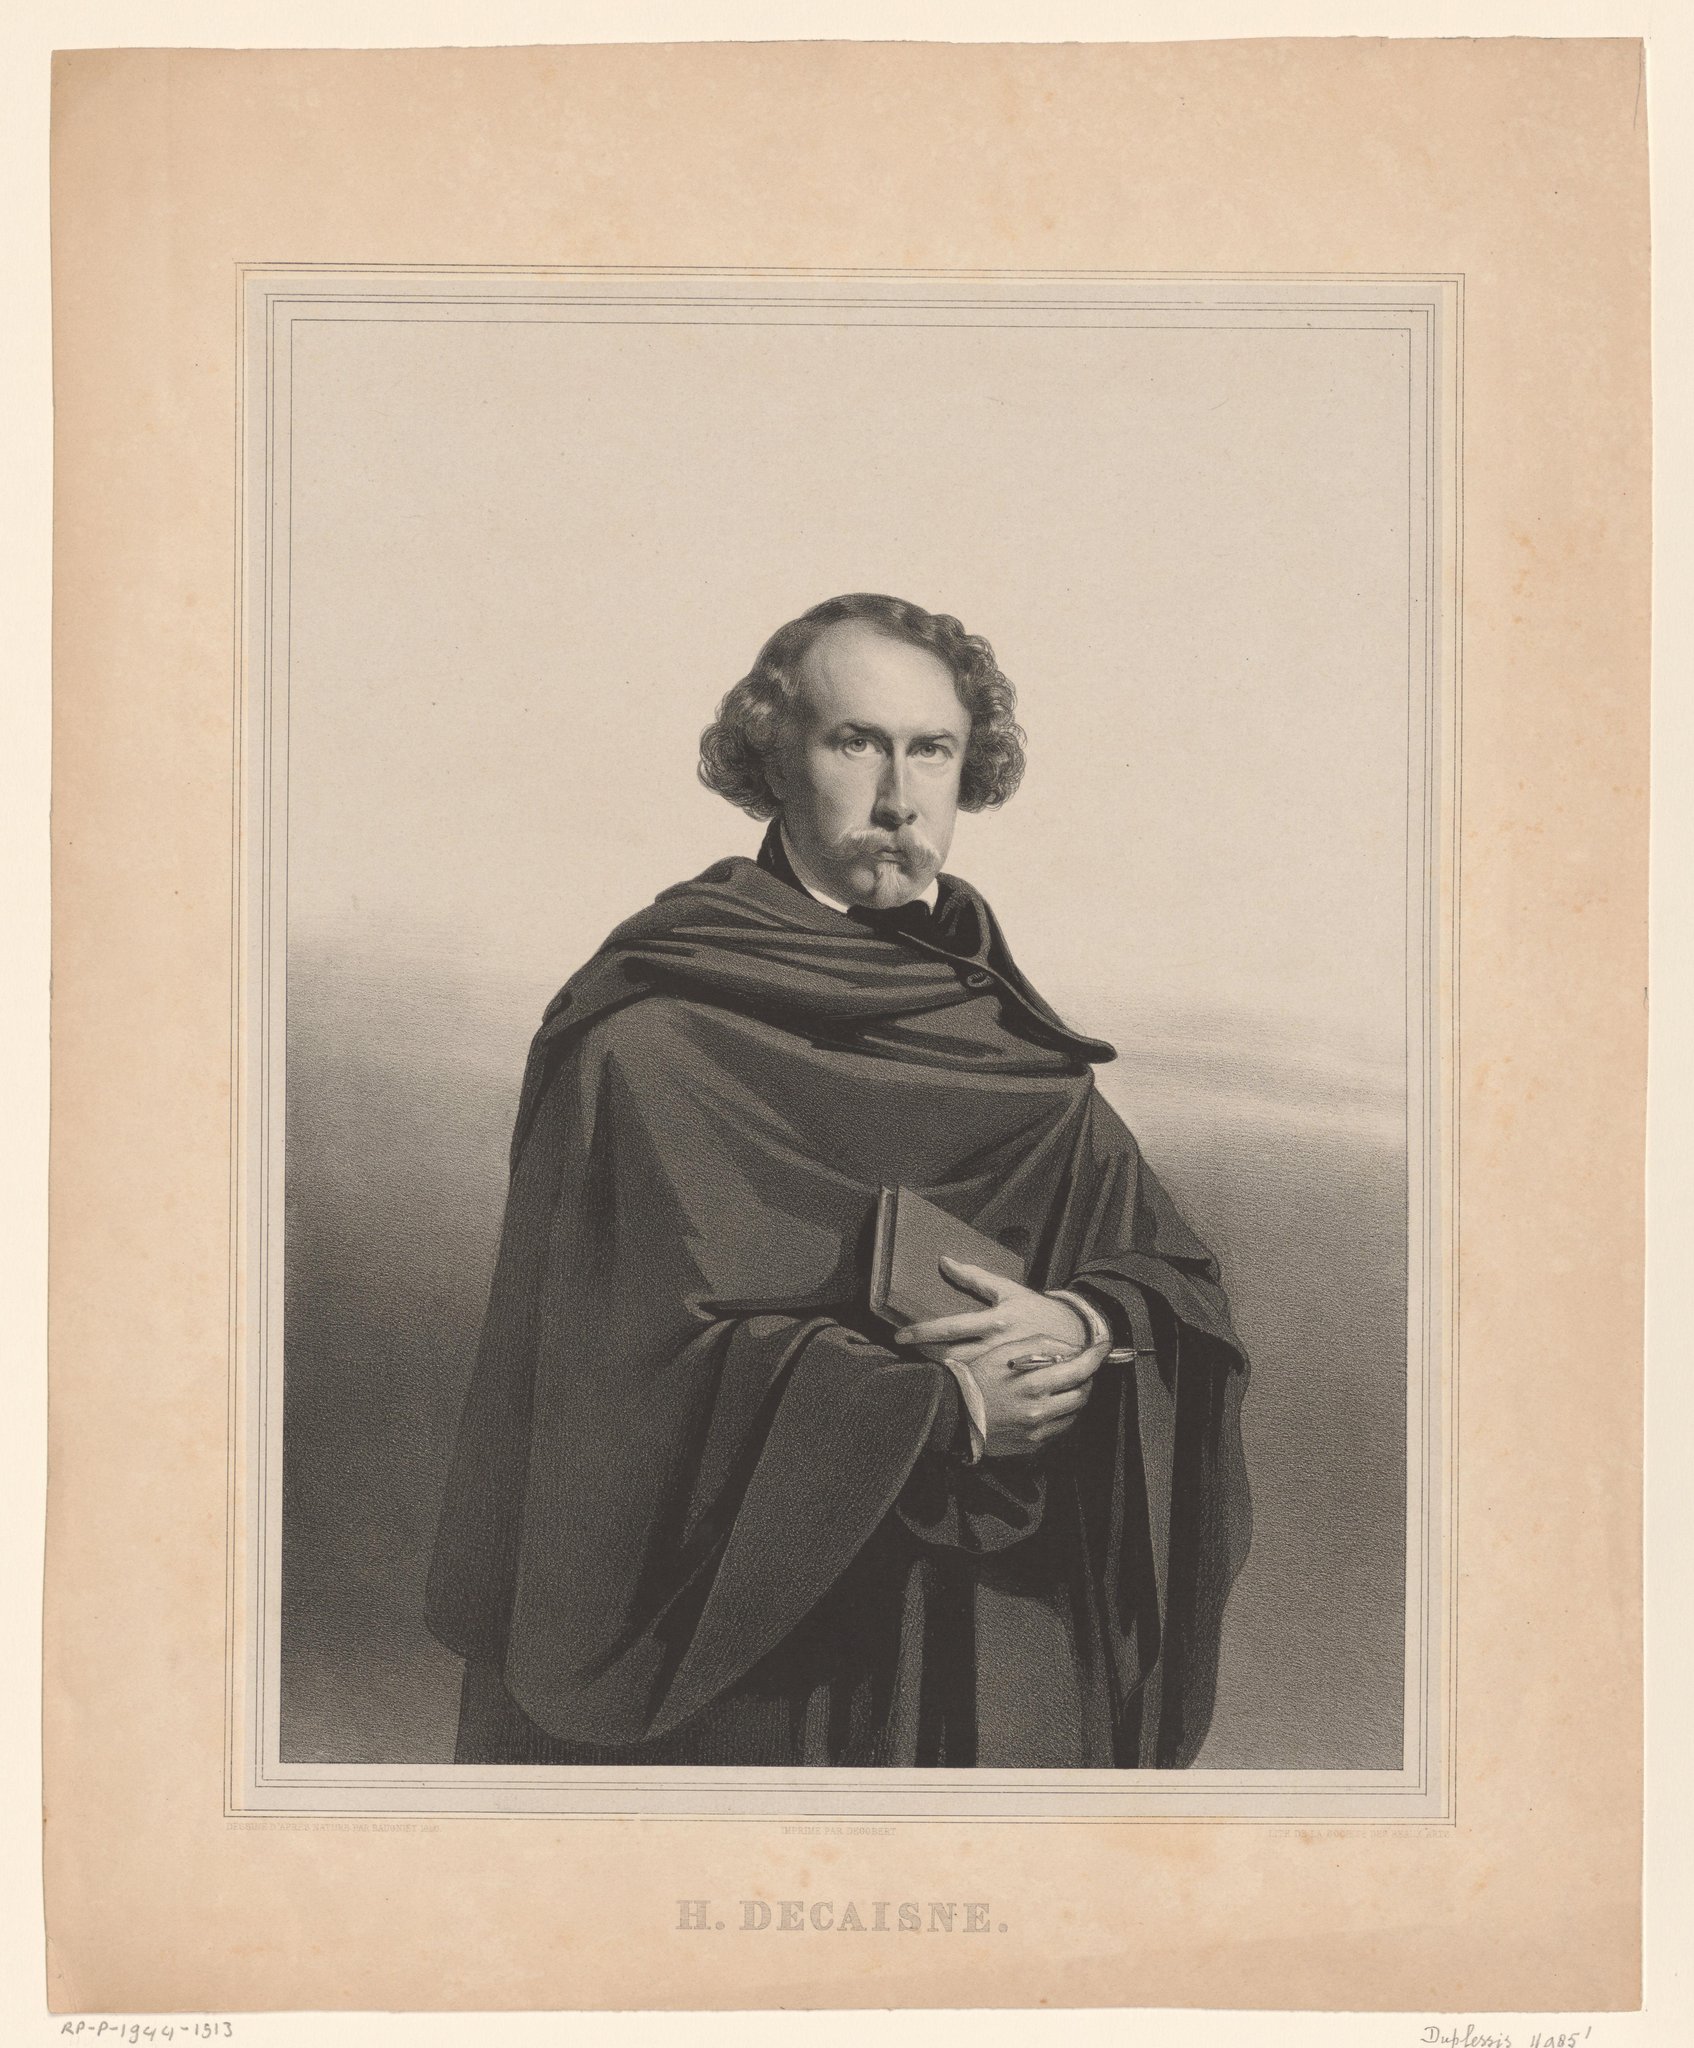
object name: print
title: Portret van Henri Decaisne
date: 1840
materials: paper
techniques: lithograph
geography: brussels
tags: brussels, paris, henri decaisne, historical persons, portrait, self-portrait of painter, tools, implements of painter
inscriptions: collector's mark: Lugt 2228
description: Prent mogelijk uit: Baugniet, Charles. Les artistes contemporains: portraits lithographiés d'après nature, accompagnés de notices sur la vie et les ouvrages de chacun d'eux. Brussel: De Wasme-Pletinckx, [1836-1840].